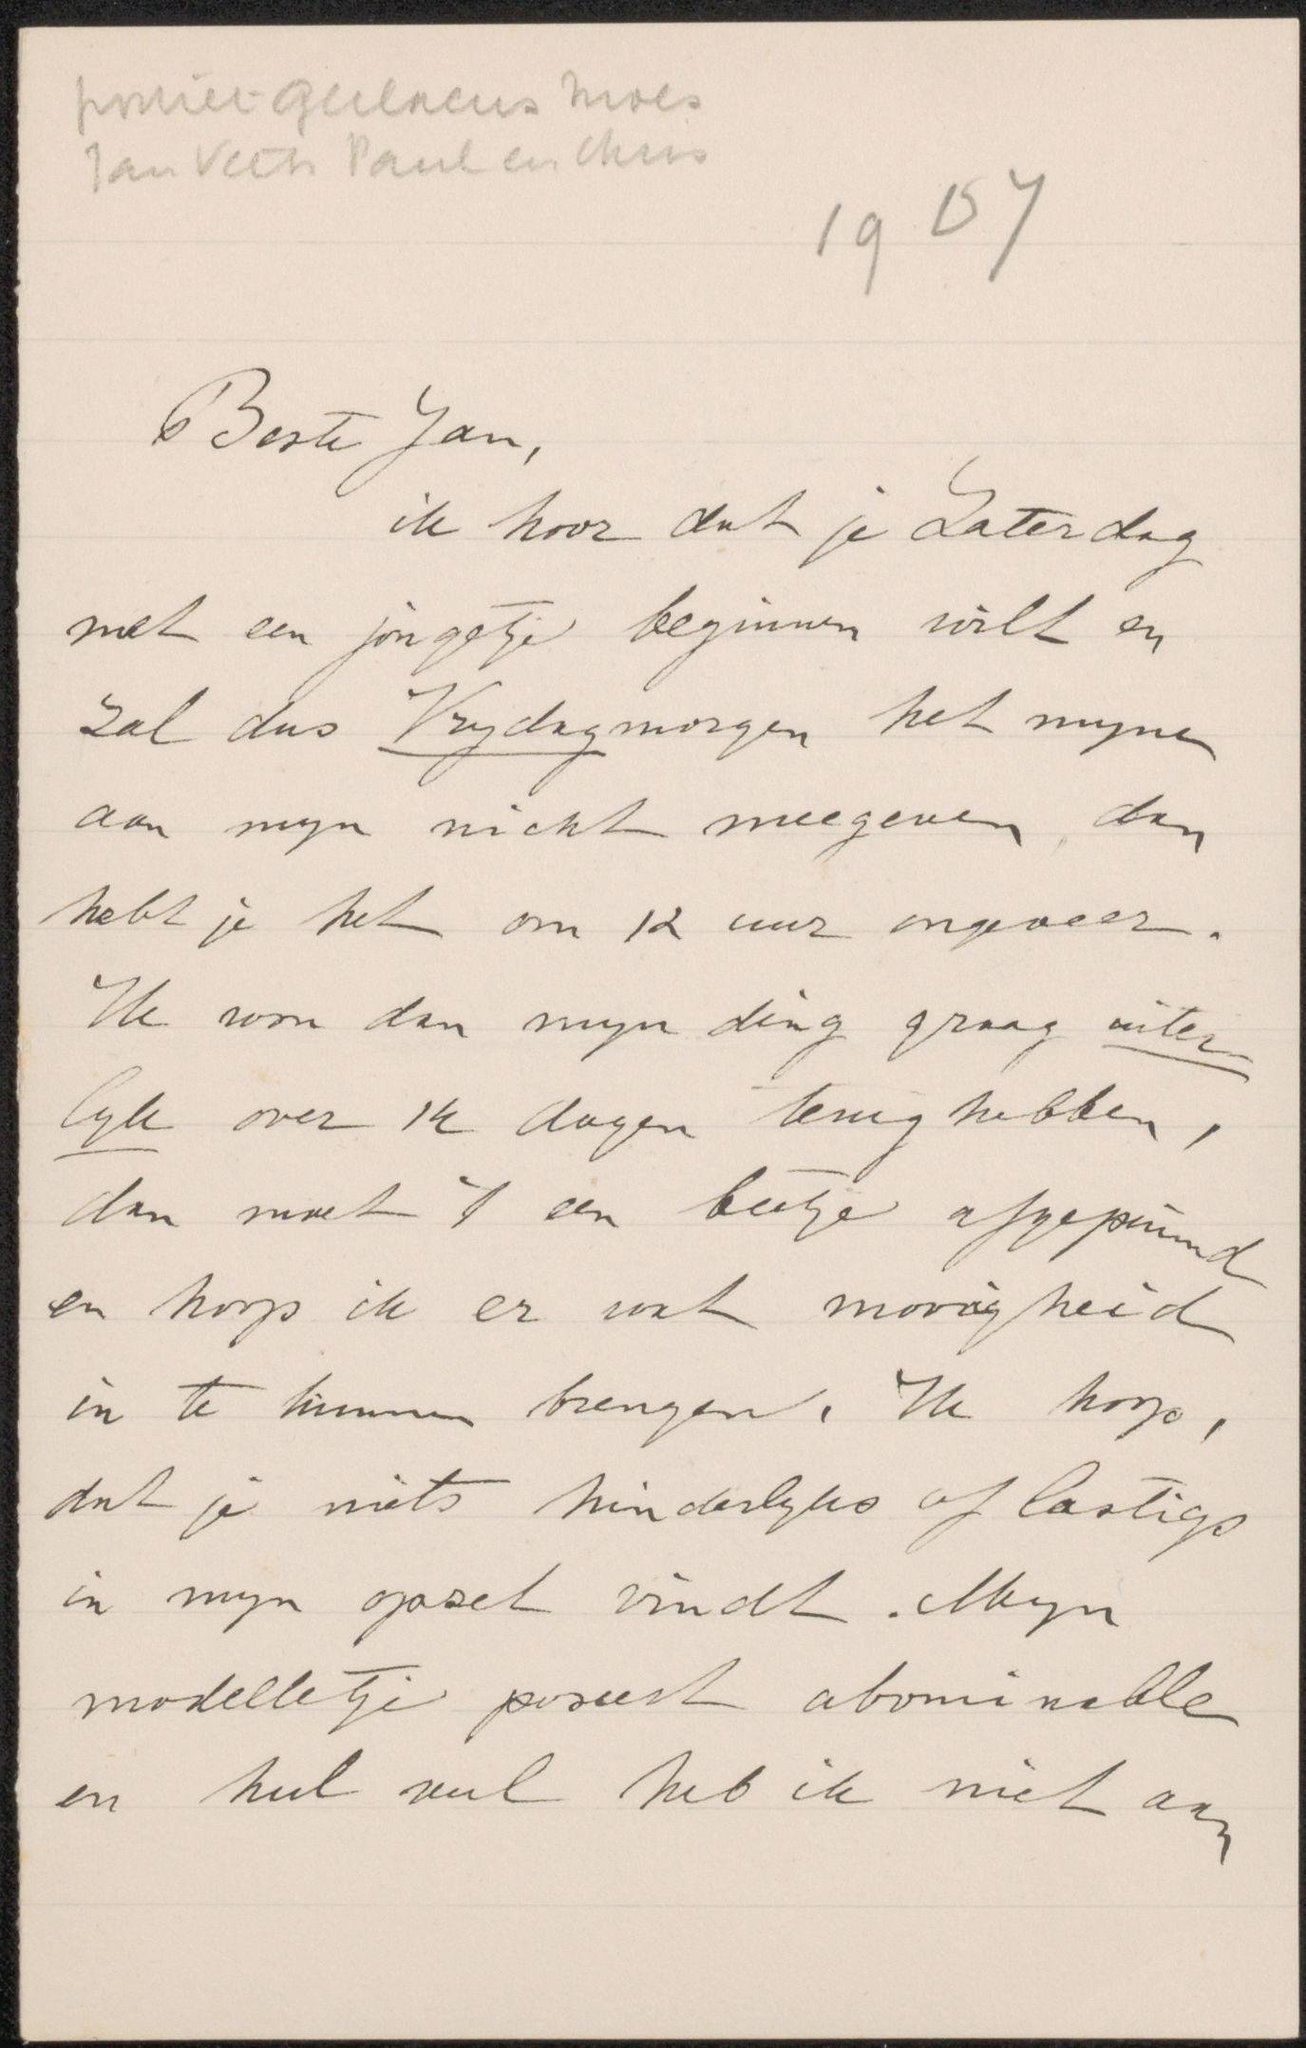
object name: letter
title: Brief aan Jan Veth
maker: wally moes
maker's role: draughtsman, print maker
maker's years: 1856-1918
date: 1874-1918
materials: ink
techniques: pen, writing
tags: dordrecht, painter, print maker, draughtsman, designer, jan veth, photography, cinematography, painting (including book-illumination, miniature-painting), historical persons (portraits and scenes from the life)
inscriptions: watermark, collector's mark: ‘RPK’